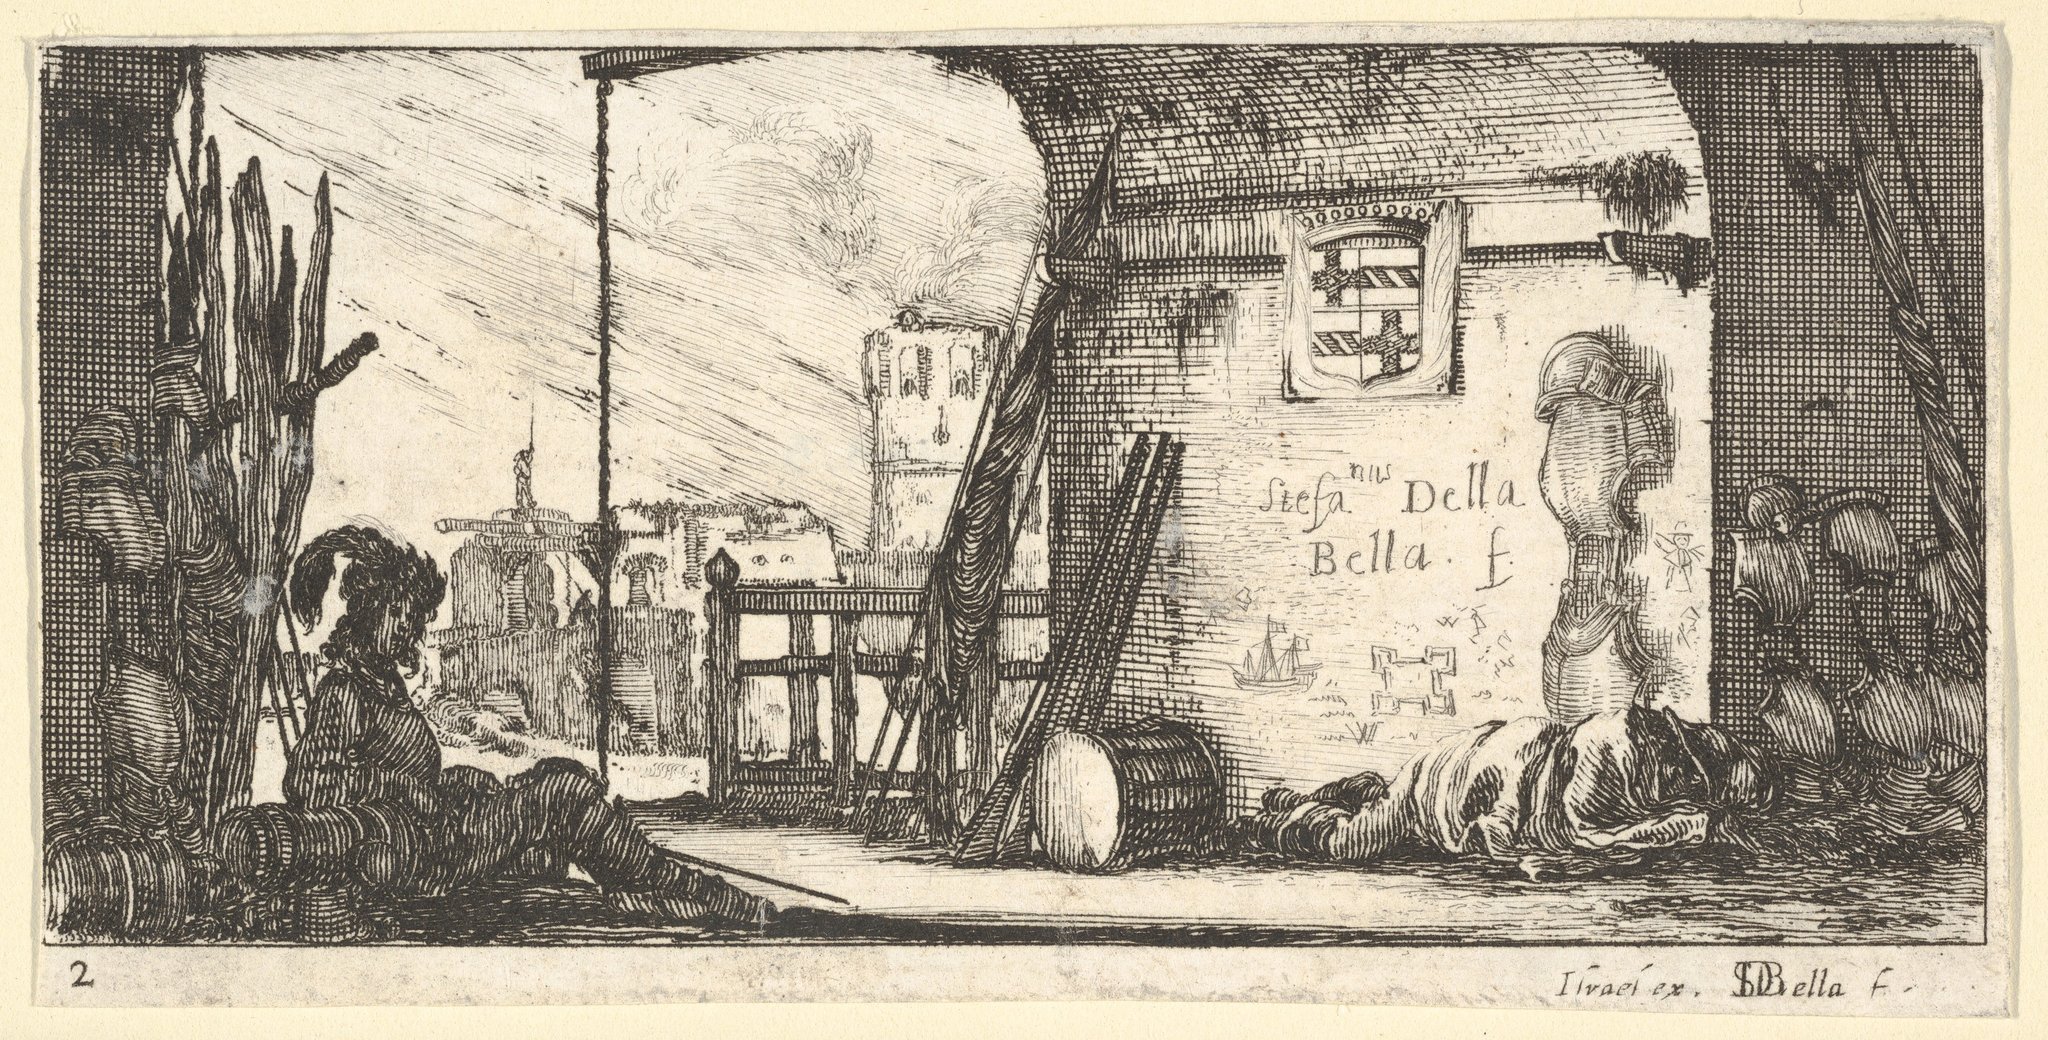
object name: print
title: Plate 2: a soldier seated to left beneath an archway, another lying on the ground to right alongside military equipment, from "Troops, cannons, and attacks on towns" (Dessins de quelques conduites de troupes, canons, et ataques de villes)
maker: stefano della bella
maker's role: artist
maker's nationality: italian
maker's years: 1610-1664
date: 1640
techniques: etching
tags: soldiers,military equipment